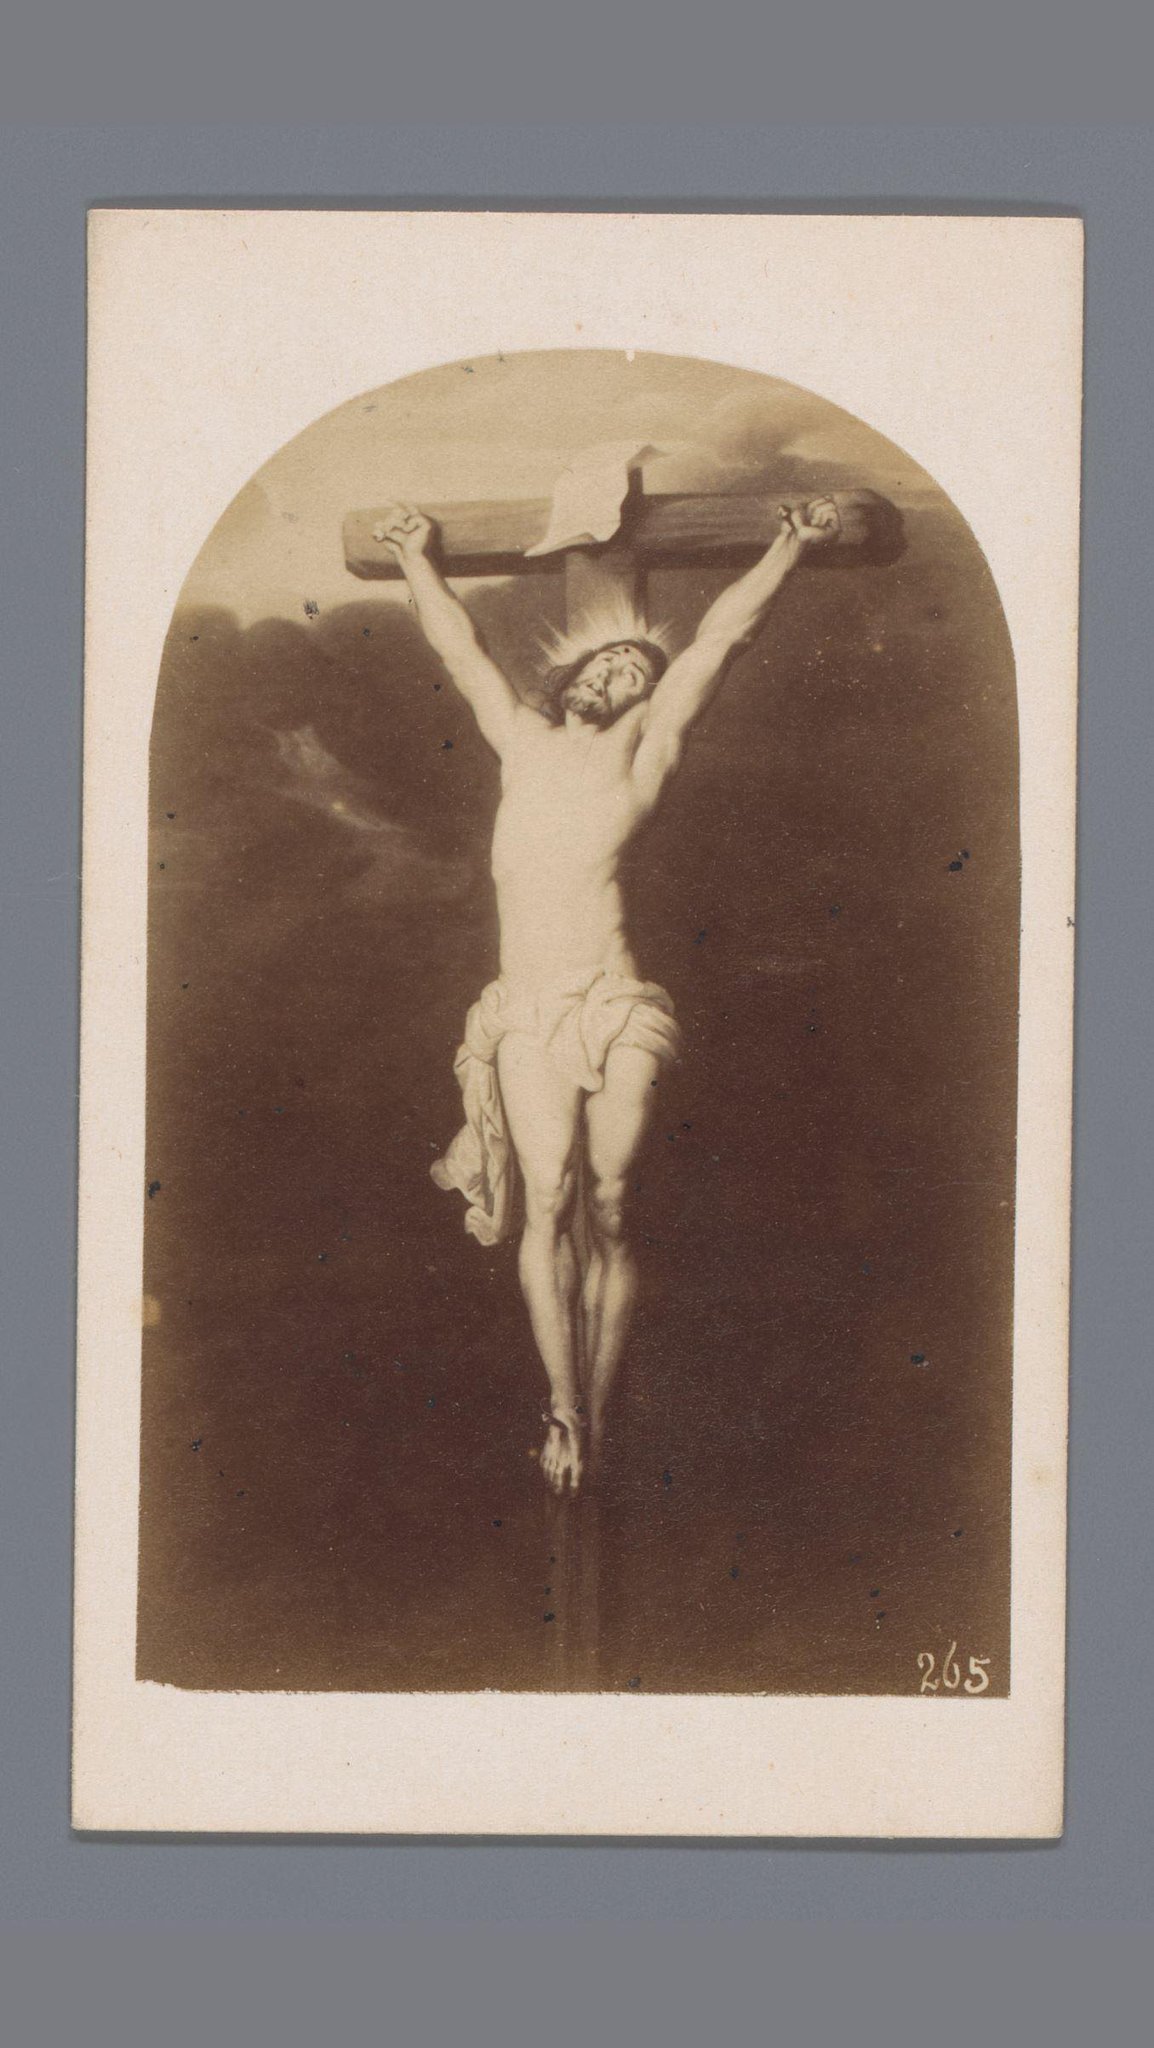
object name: photograph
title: Anvers Tableaux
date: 1858-1866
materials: cardboard, paper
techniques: albumen print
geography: antwerp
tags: christ on the cross on golgotha (alone, without bystanders)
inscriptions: number: ‘265’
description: Tegenwoordig bevindt dit schilderij zich in het Kunsthistorisches Museum in Wenen.